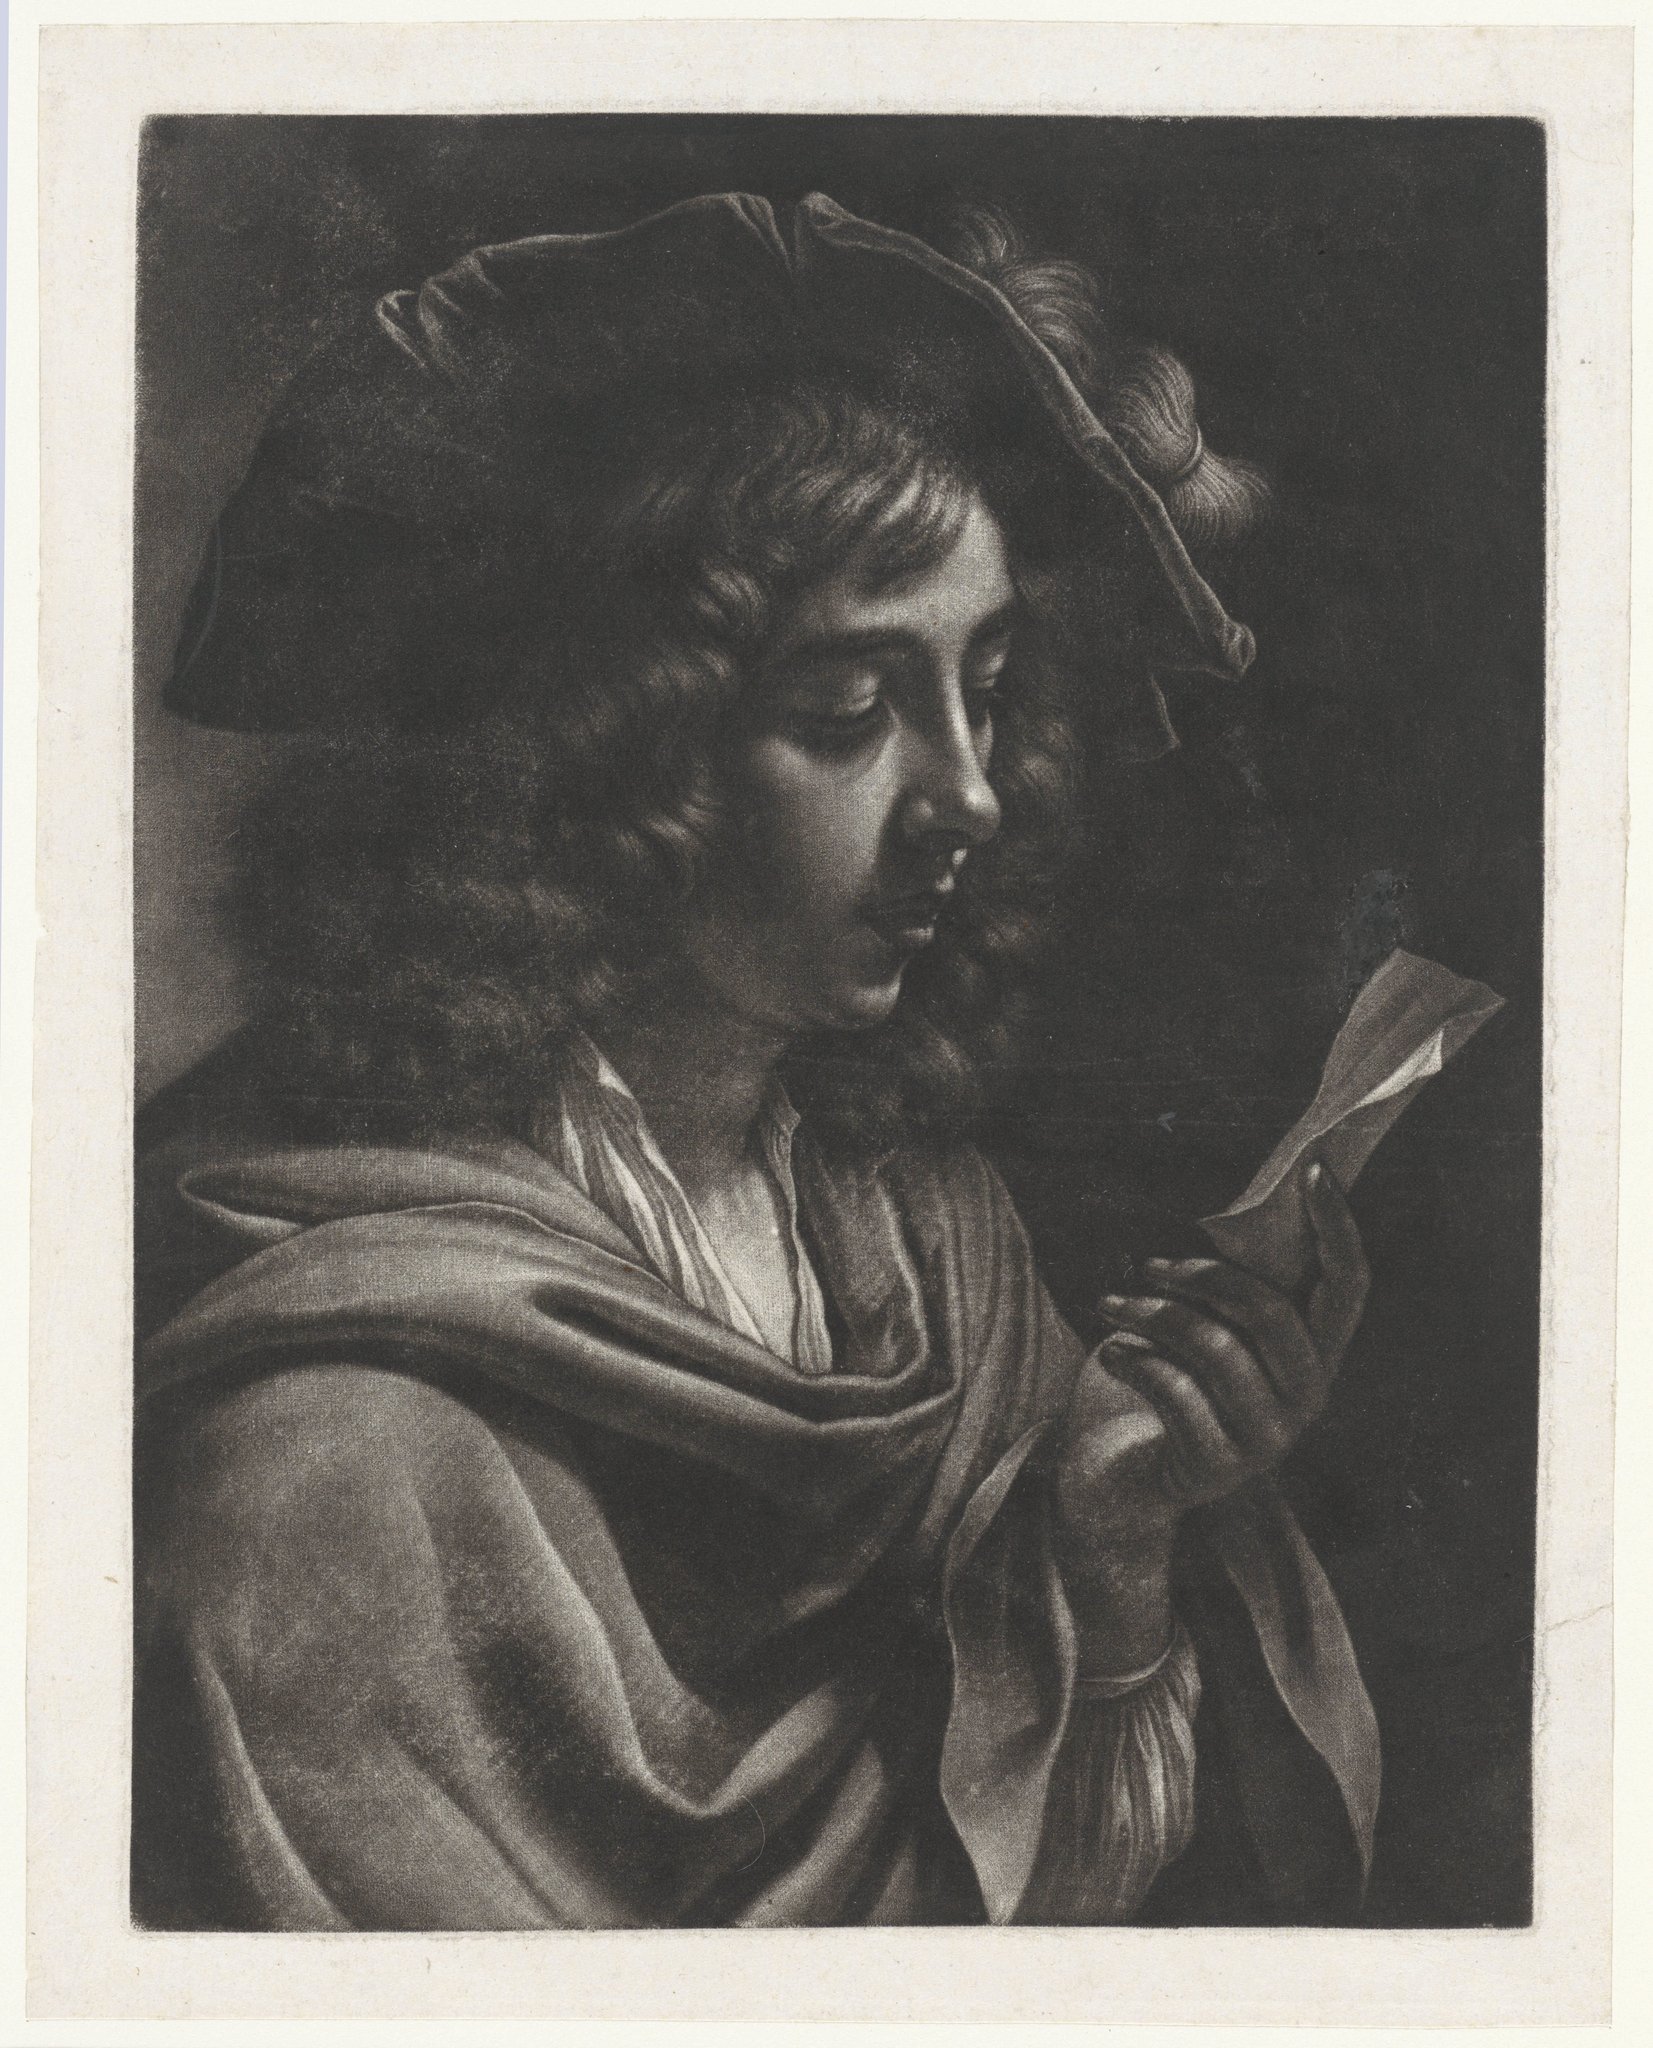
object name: print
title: Brieflezende jongen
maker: wallerant vaillant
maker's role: draughtsman, painter, print maker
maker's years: 1623-1677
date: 1658-1677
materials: paper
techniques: mezzotint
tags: reading, head-gear: hat (+ men's clothes)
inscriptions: collector's mark: Lugt 10, collector's mark: Lugt 11